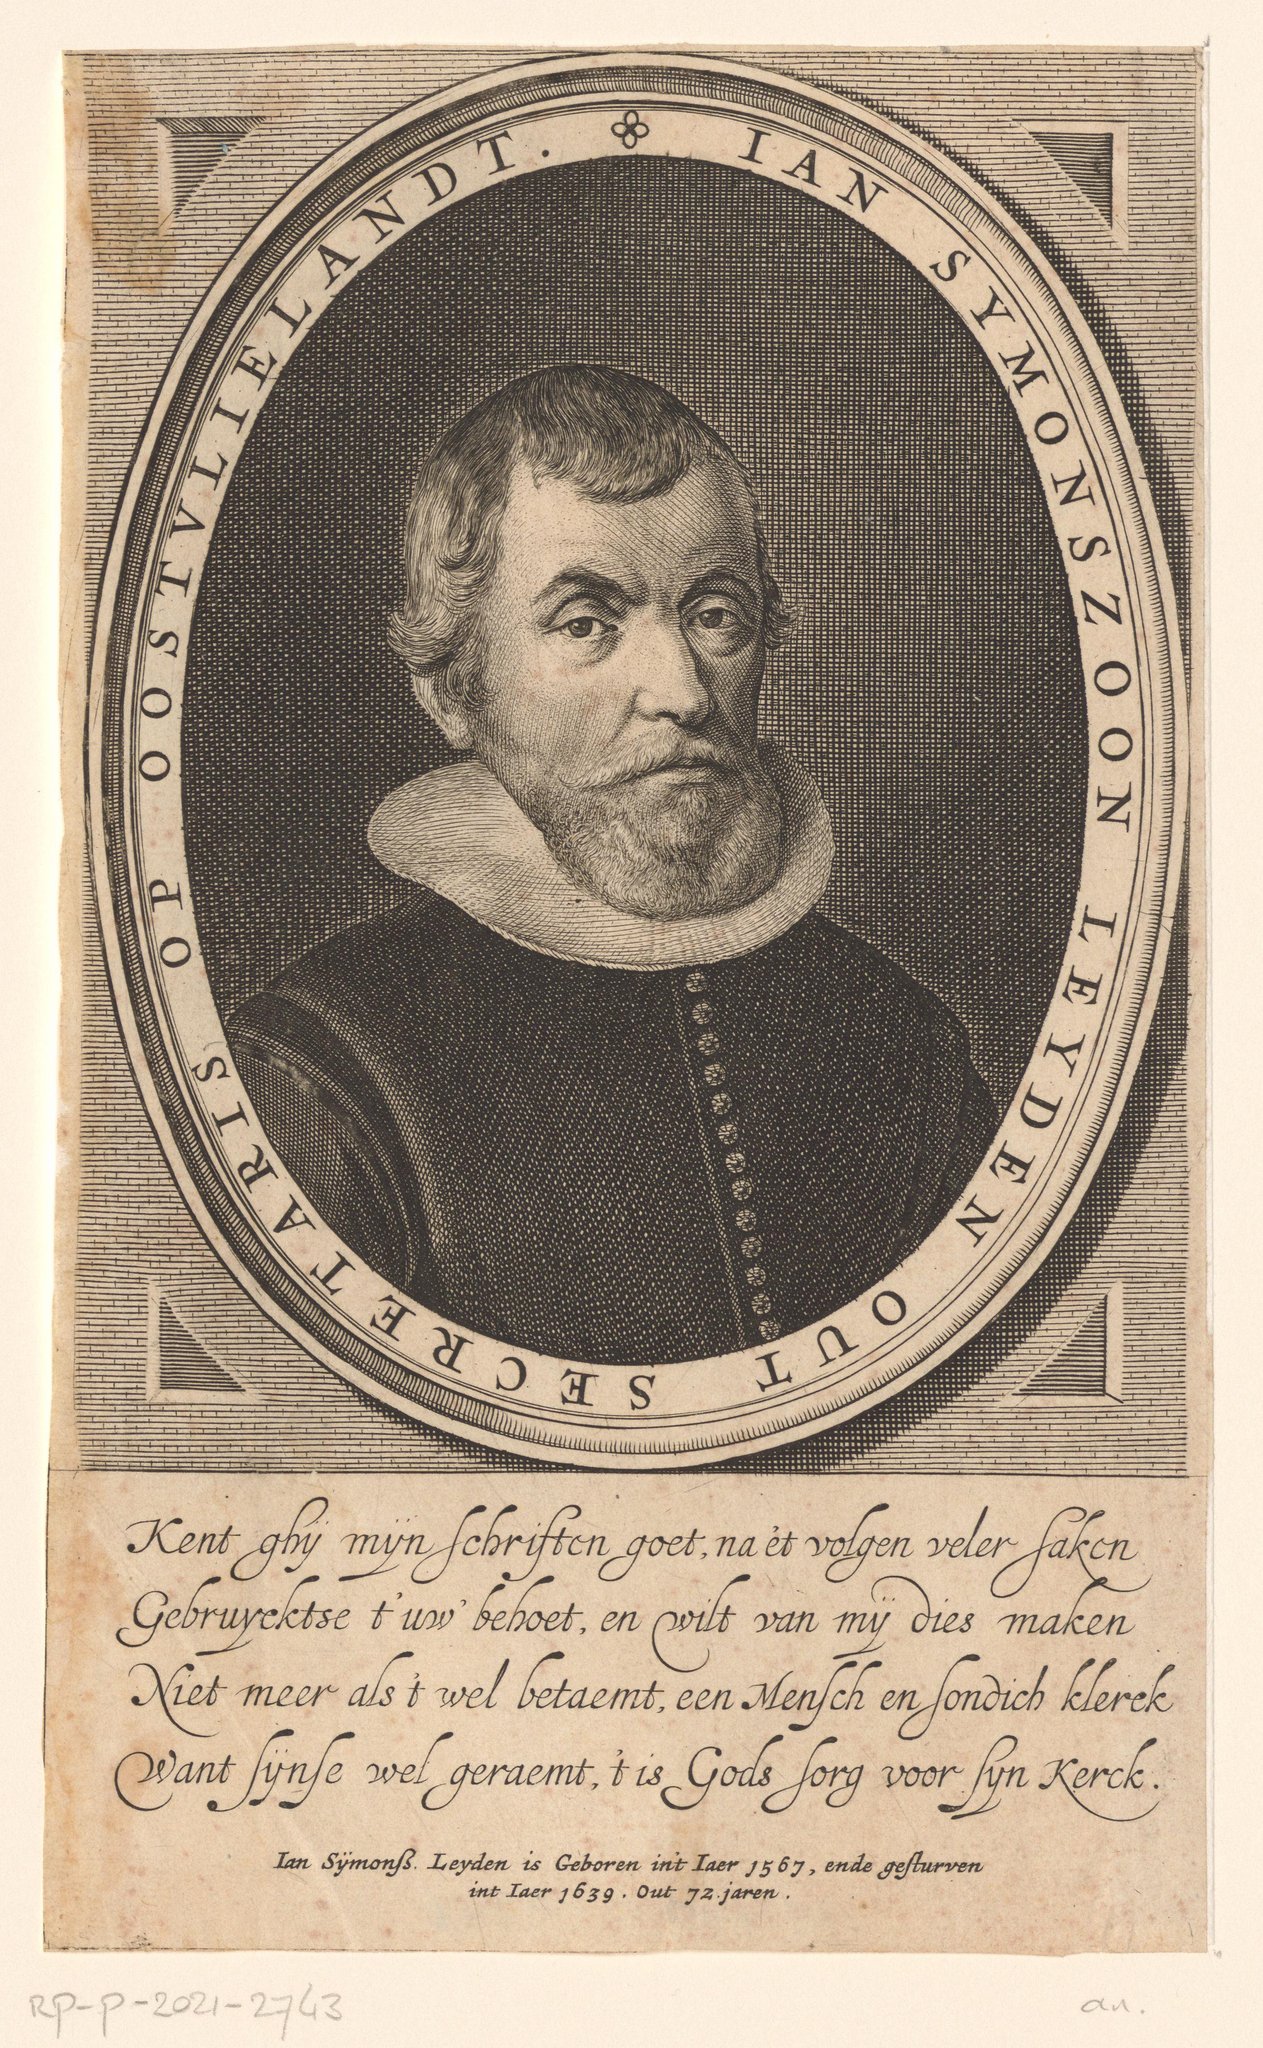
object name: print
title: Portret van Jan Symonsz. Leyden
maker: Anonymous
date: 1639-1670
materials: paper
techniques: engraving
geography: northern netherlands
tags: ornament ~ medallion, historical persons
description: Met vierregelig vers in het Nederlands onder het portret.